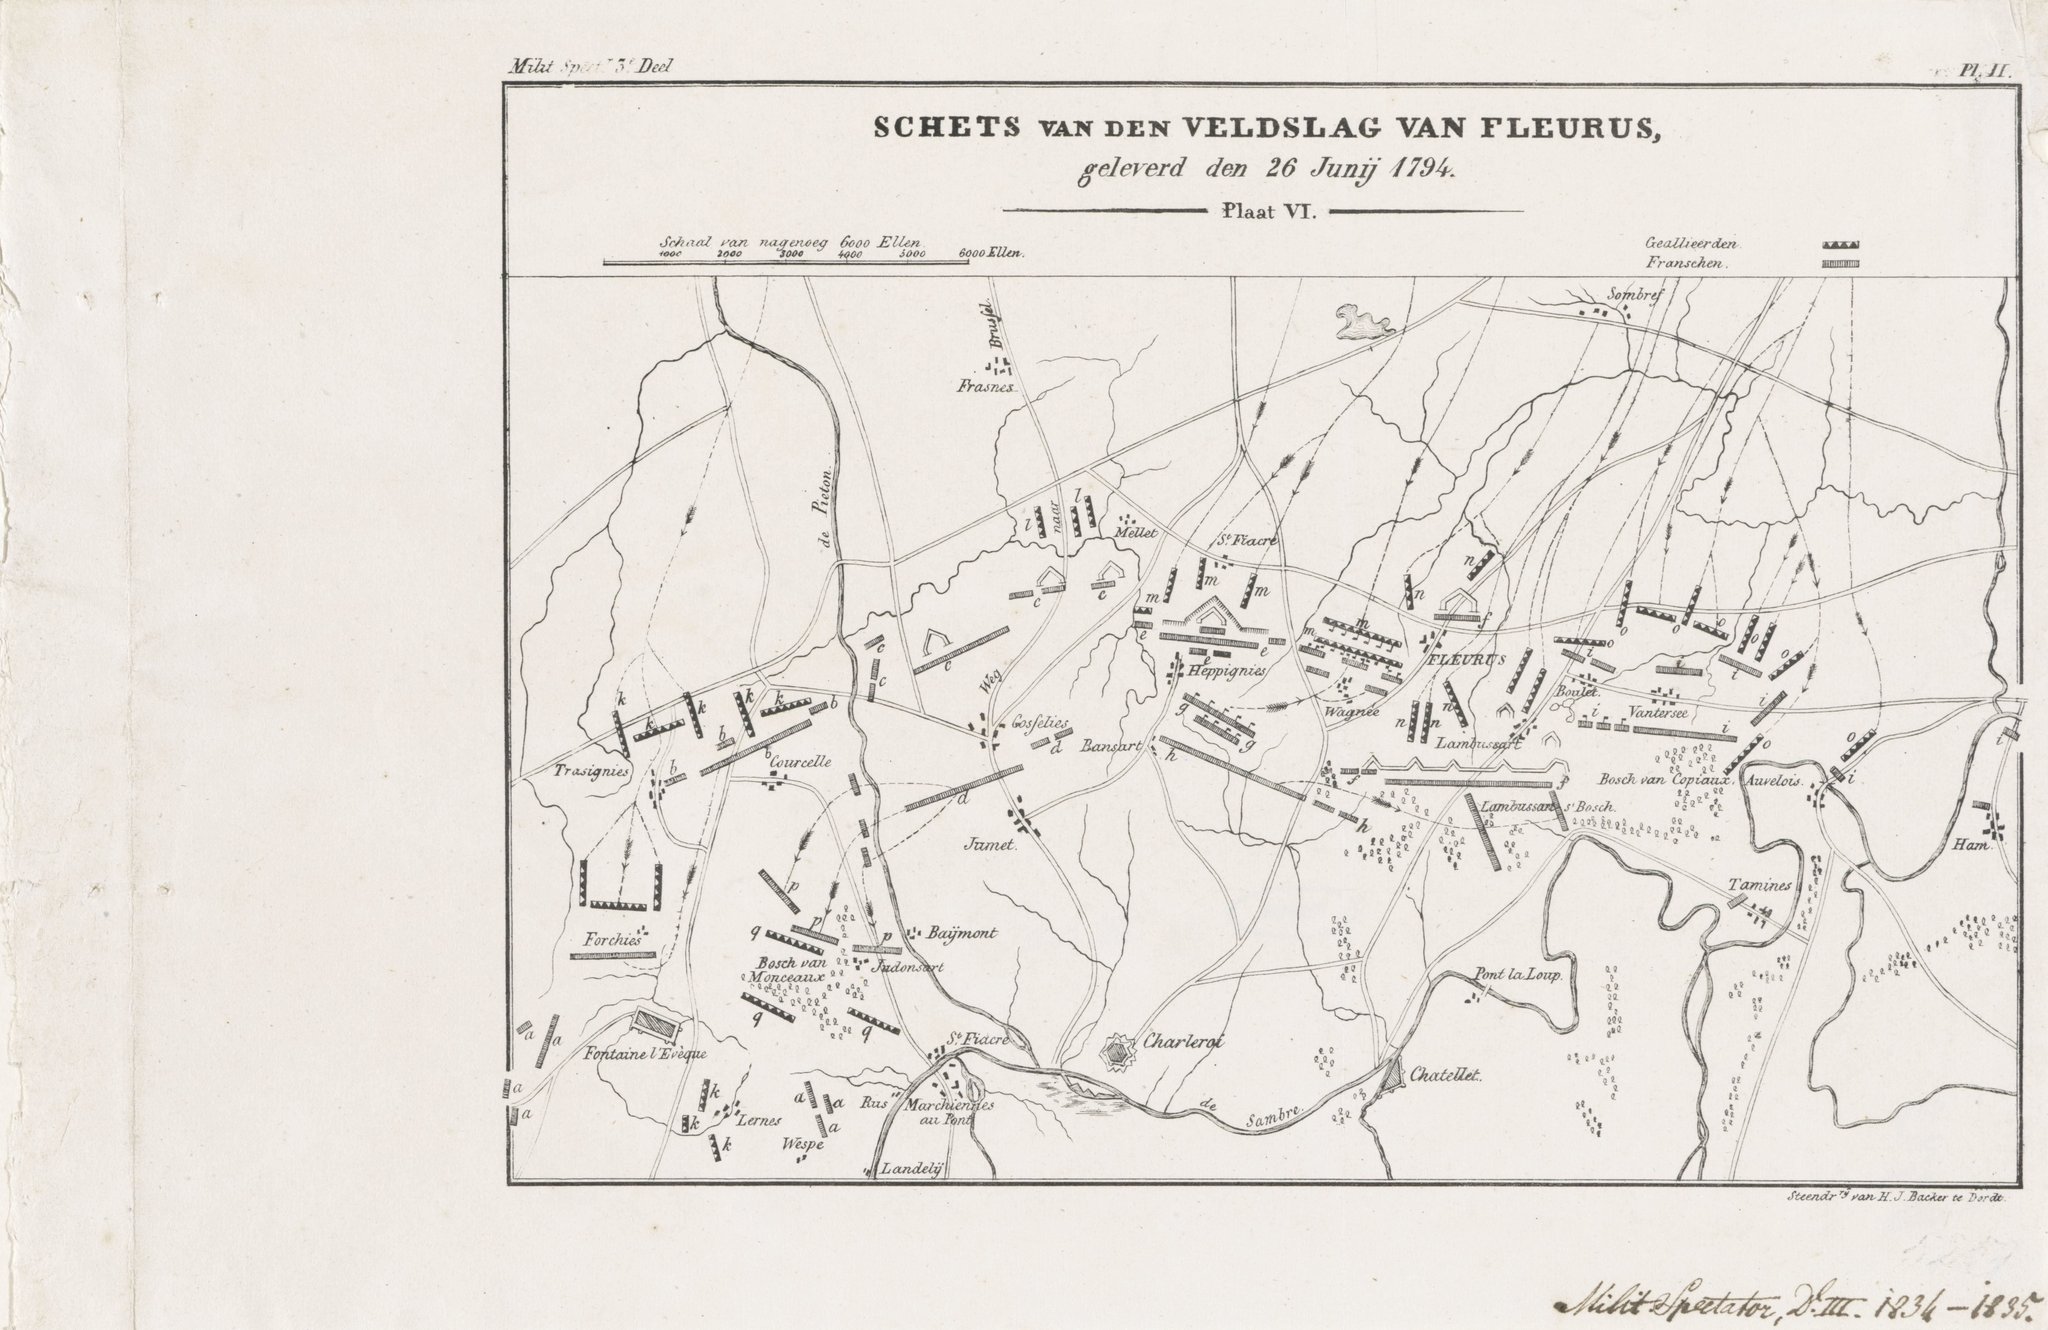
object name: map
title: Kaart met de posities van de legers tijdens de slag bij Fleurus, juni 1794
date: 1834-1835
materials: paper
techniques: lithograph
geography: dordrecht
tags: maps of separate countries or regions, battle arrays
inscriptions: collector's mark: Lugt 2228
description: Kaart met de posities van de Geallieerde en Franse legers tijdens de slag bij Fleurus, 26 juni 1794. Franse overwinning op de Oostenrijkers. Gemerkt bovenaan: Milit. Spectr. IIIde Deel / Pl: II.